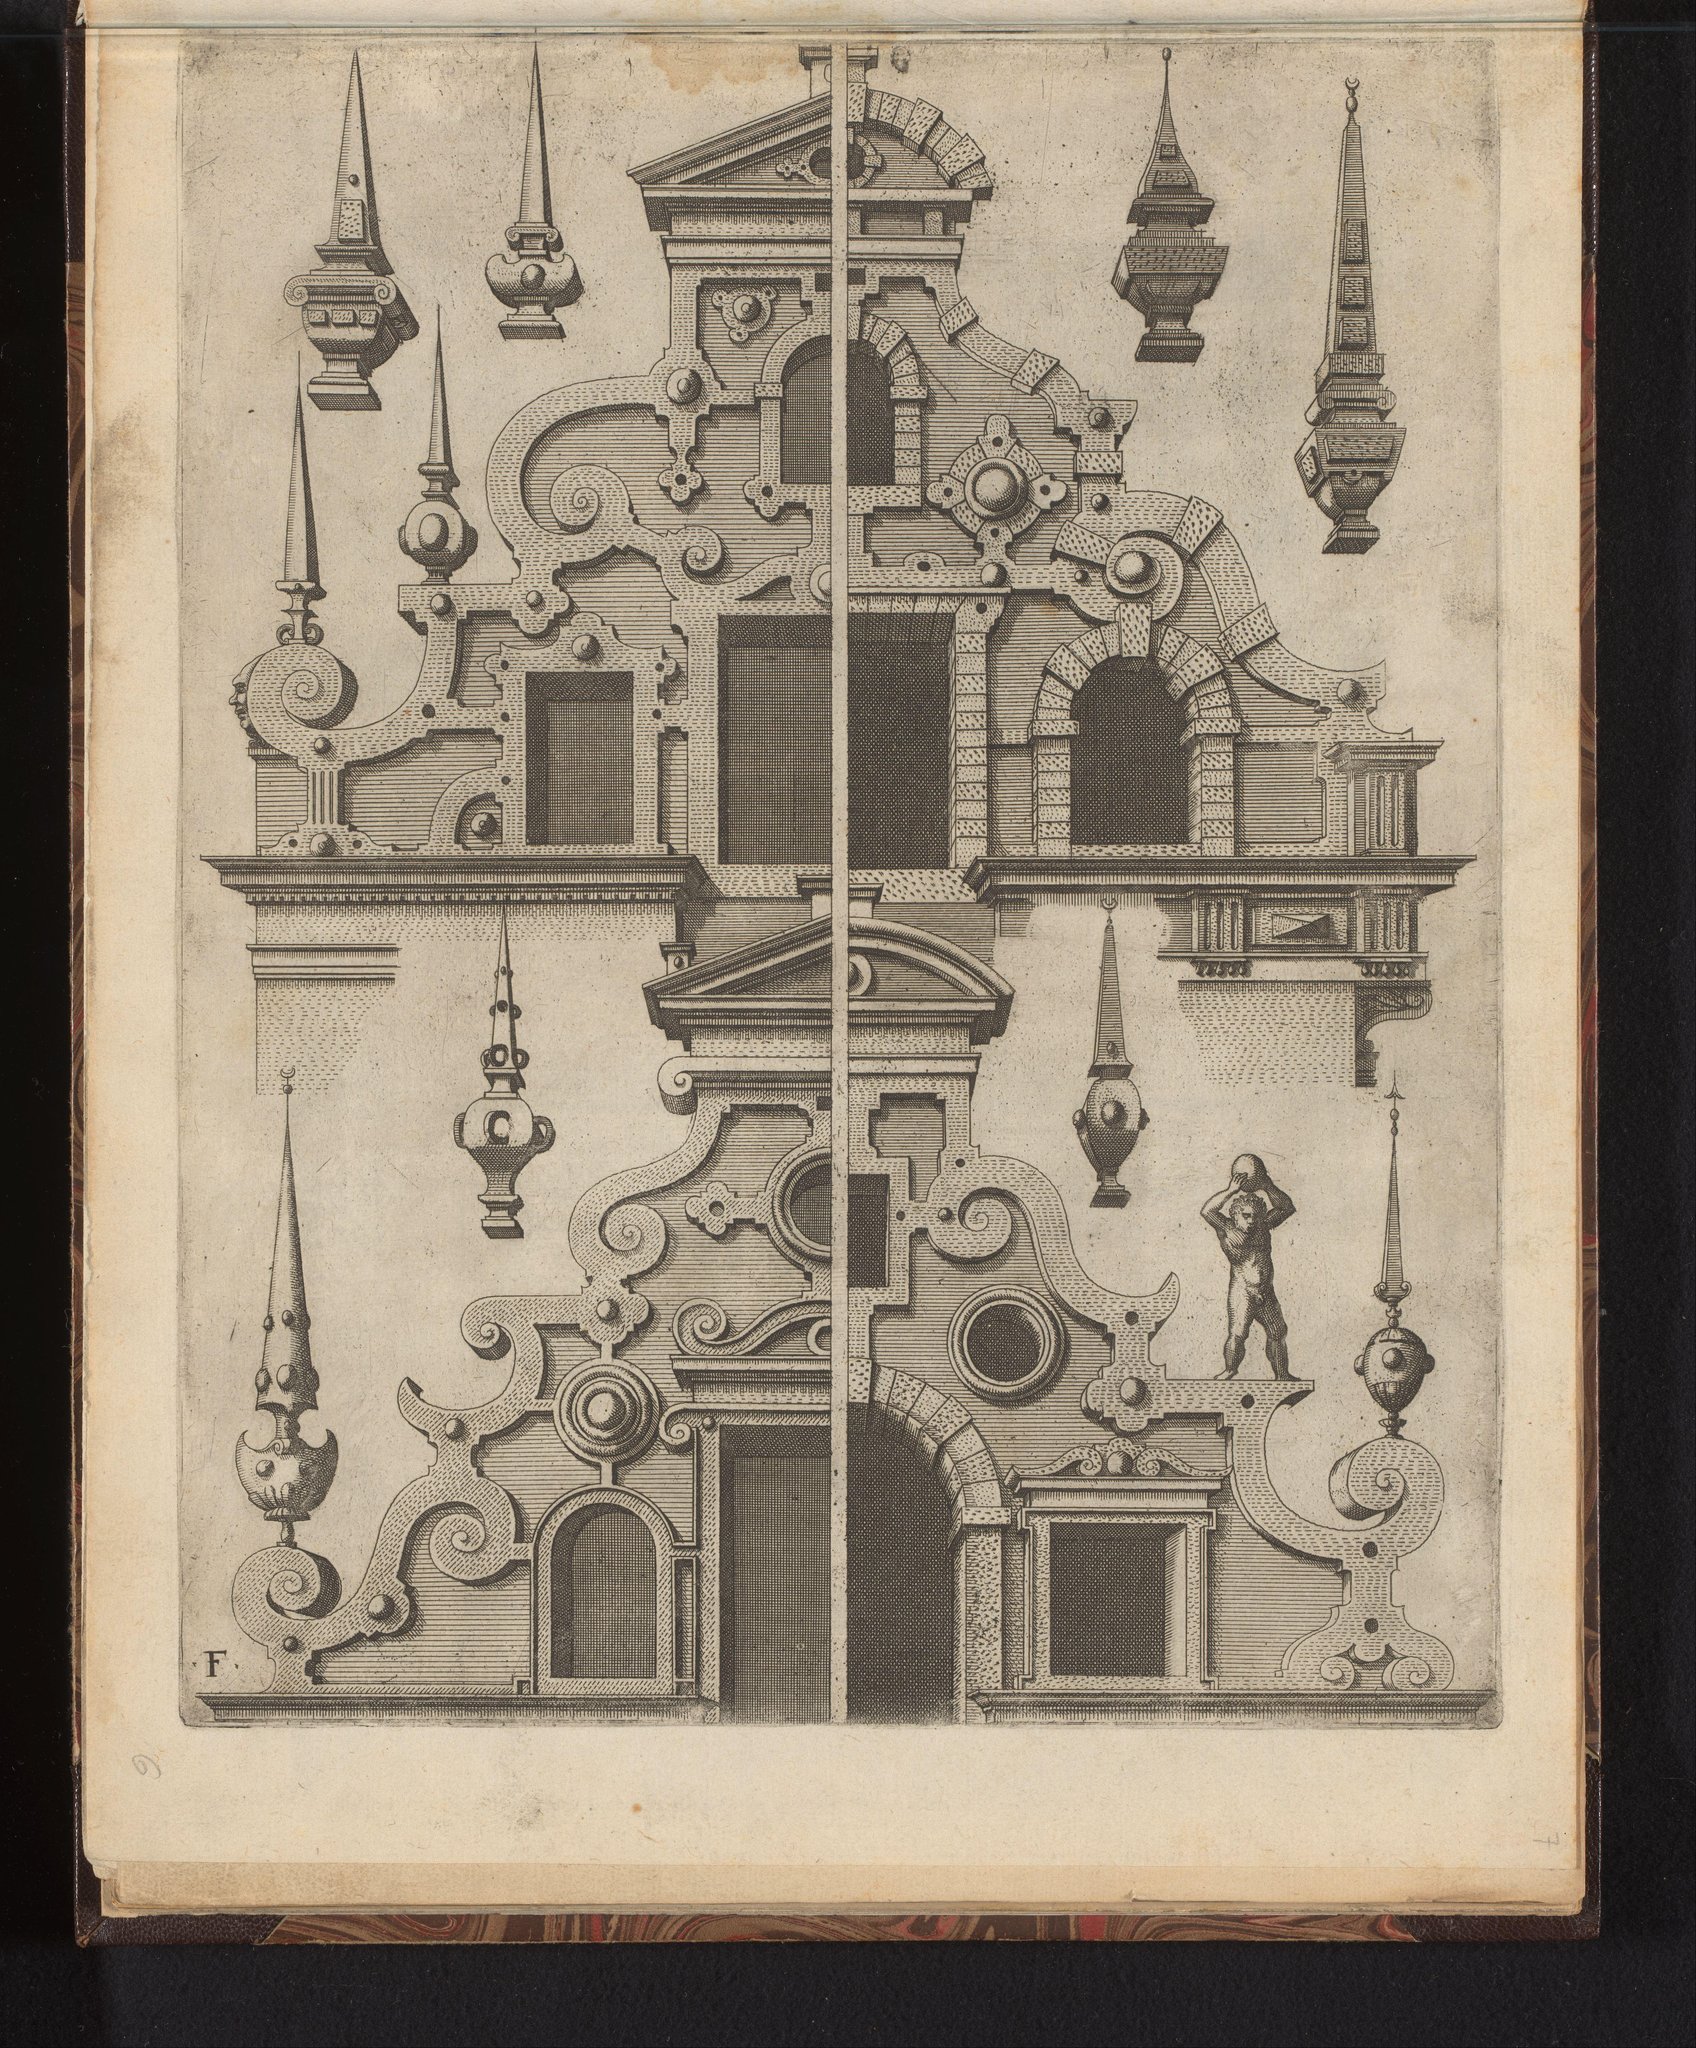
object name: ornament print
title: Vier halve topgevels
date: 1565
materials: paper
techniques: etching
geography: antwerp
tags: decorated gable, doric order ~ architecture, ionic order ~ architecture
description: Vier halve topgevels met beslagwerk en zes losse bekronende elementen. Blad F. De prent maakt deel uit van een album.